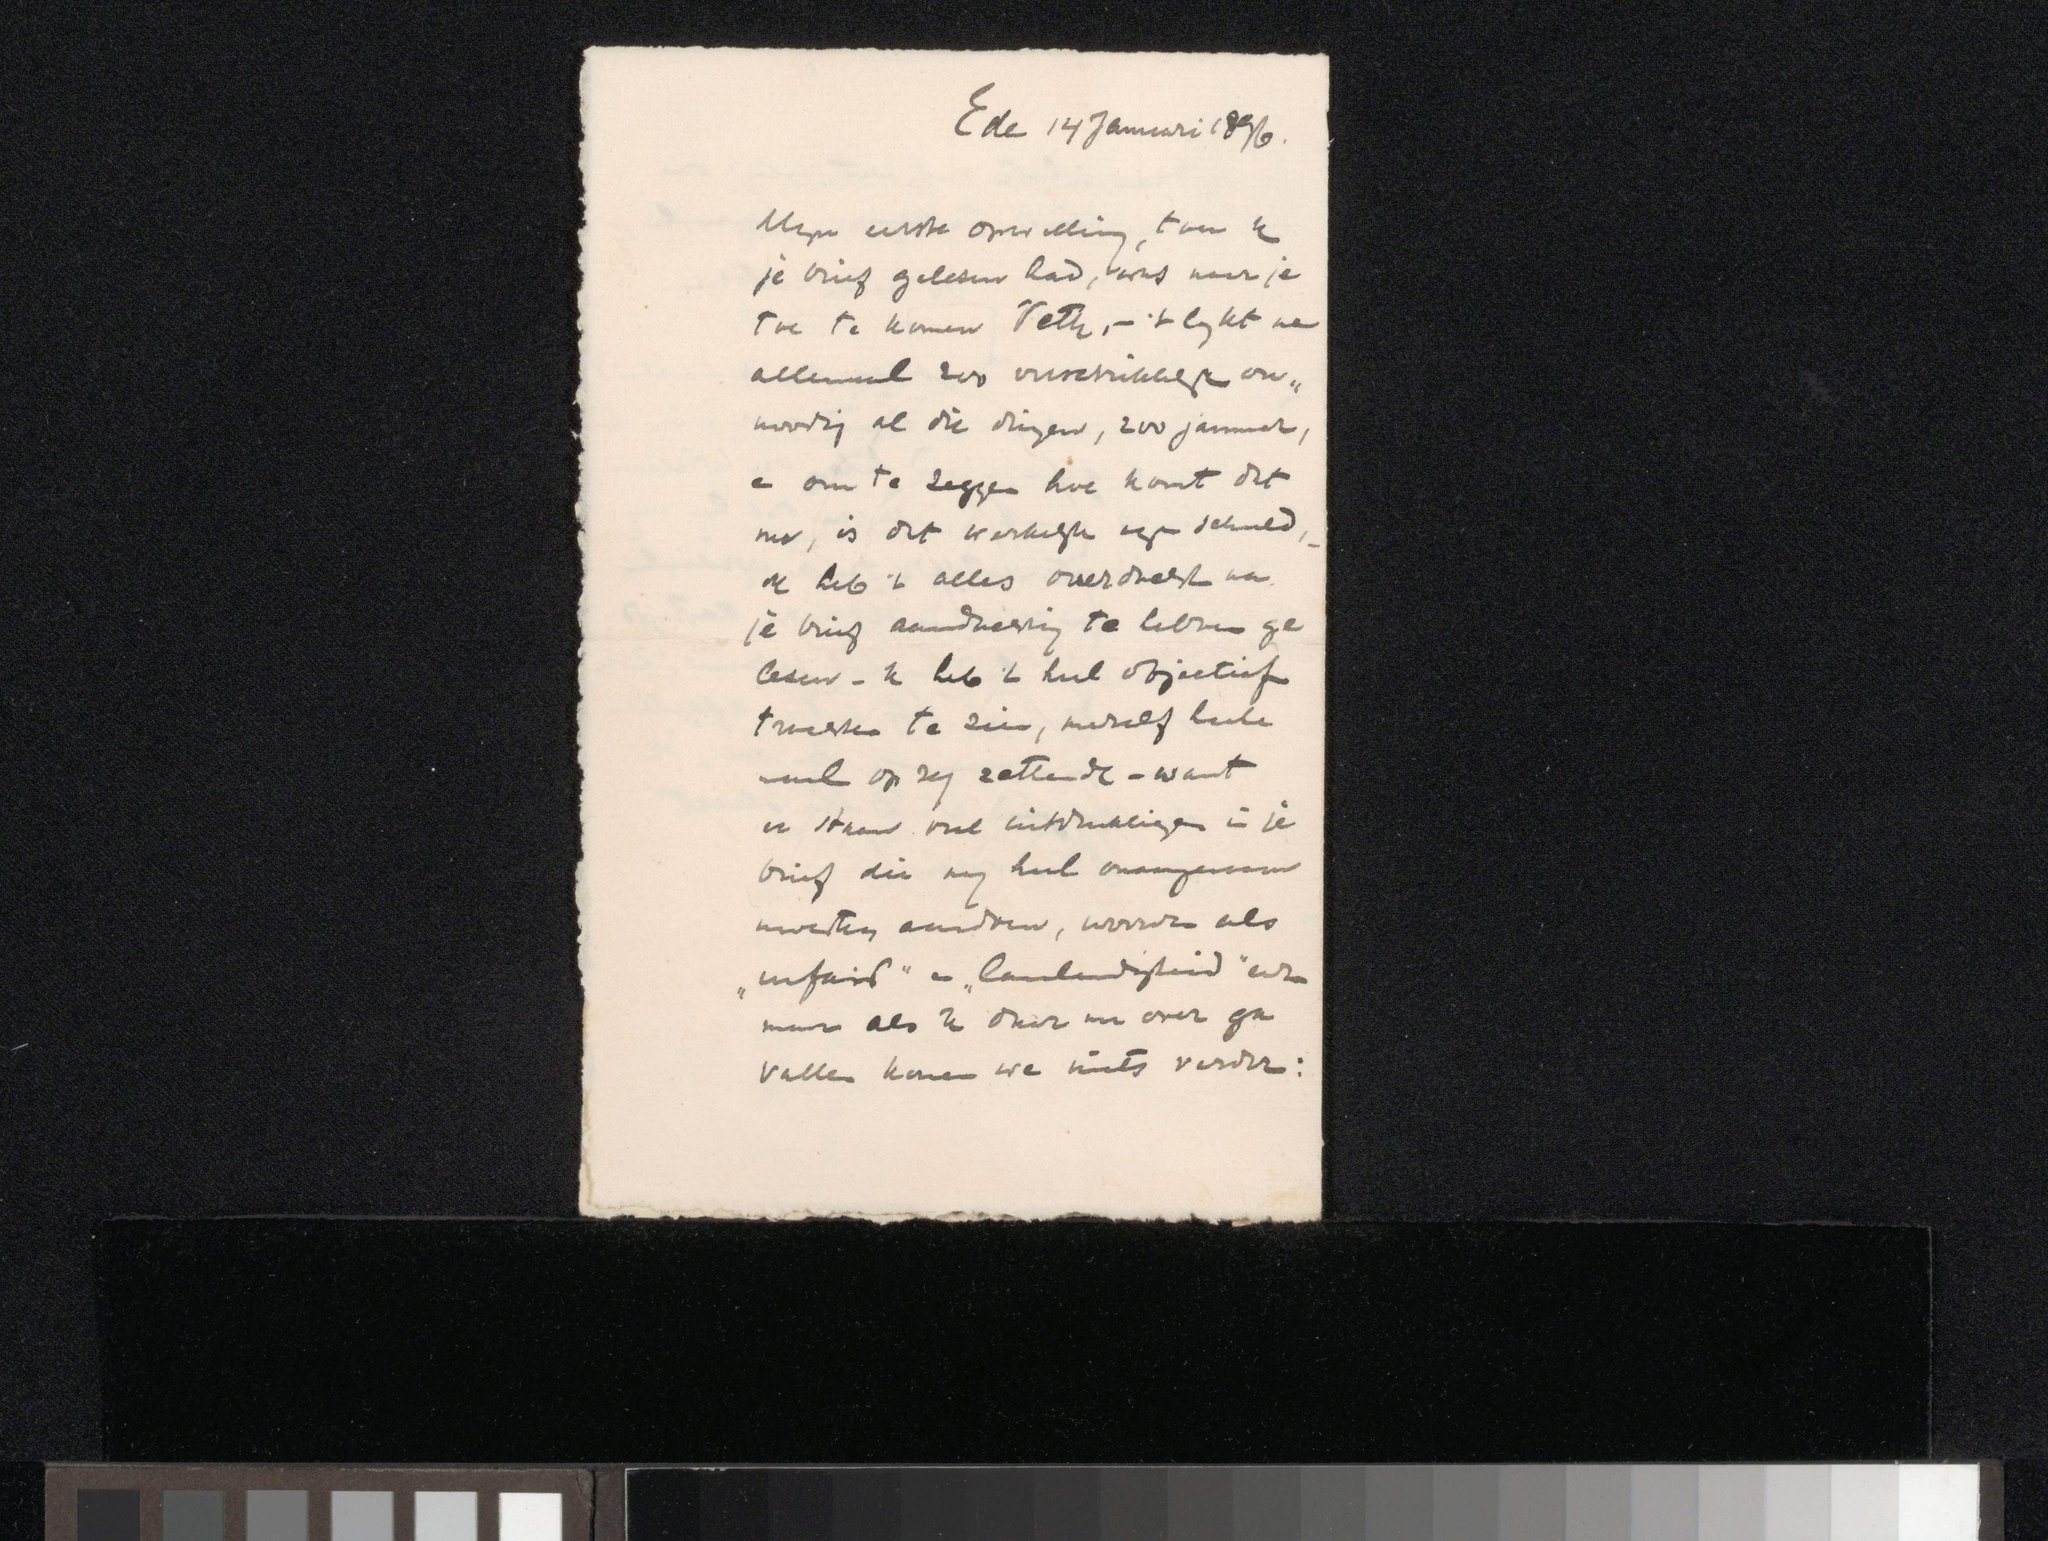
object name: letter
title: Brief aan Jan Veth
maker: willem witsen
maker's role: draughtsman, painter, print maker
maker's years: 1860-1923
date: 1896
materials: ink, paper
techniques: pen, writing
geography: ede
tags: designer, jan veth, willem kloos, passions, emotions, affections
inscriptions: watermark, collector's mark: ‘RPK’